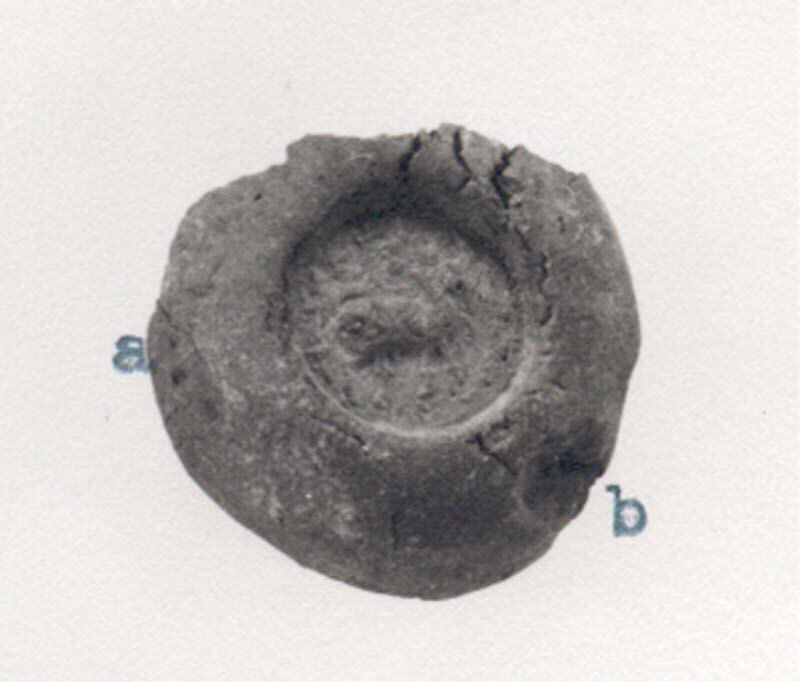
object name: sealing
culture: sasanian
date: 601-700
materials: clay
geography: iran